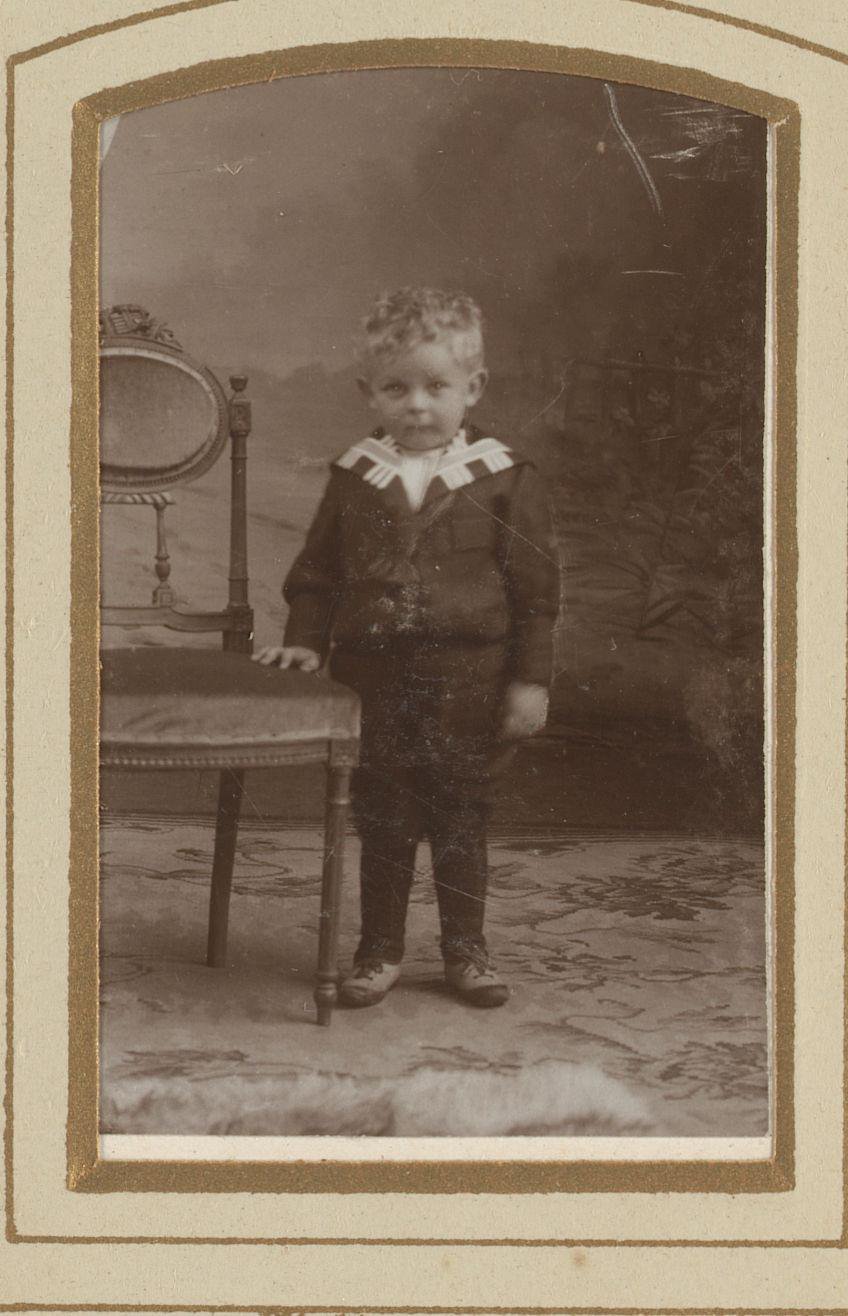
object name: carte de visite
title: Portret van een jongen, staand bij een stoel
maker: josephus hendrikus petrus coppens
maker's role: fotograaf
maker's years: 1864-1941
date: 1889-1925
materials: cardboard, photographic support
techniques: collodion silver print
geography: purmerend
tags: historical persons, toddler (male), chair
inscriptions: inscription: ‘J.H.P. Coppens/ PURMEREND.’